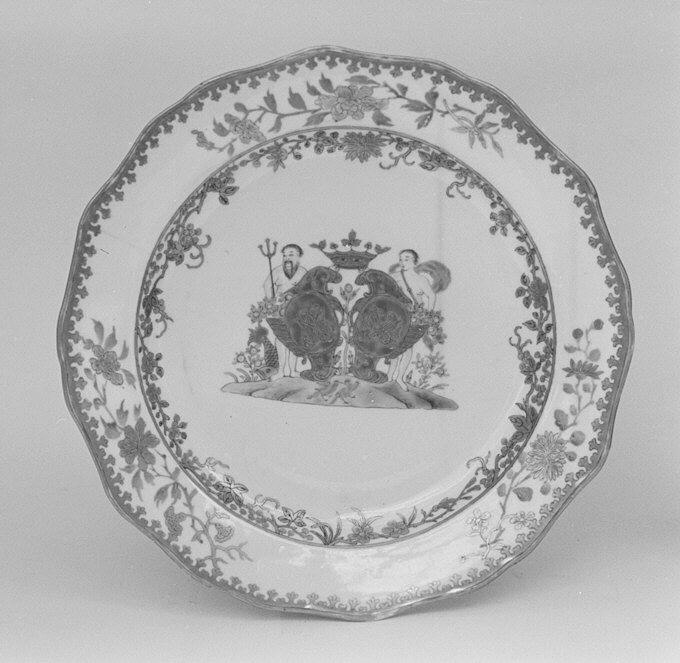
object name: dinner plate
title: Dinner plate (part of a service)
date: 1760-1770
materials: hard paste porcelain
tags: human figures,flowers,coat of arms